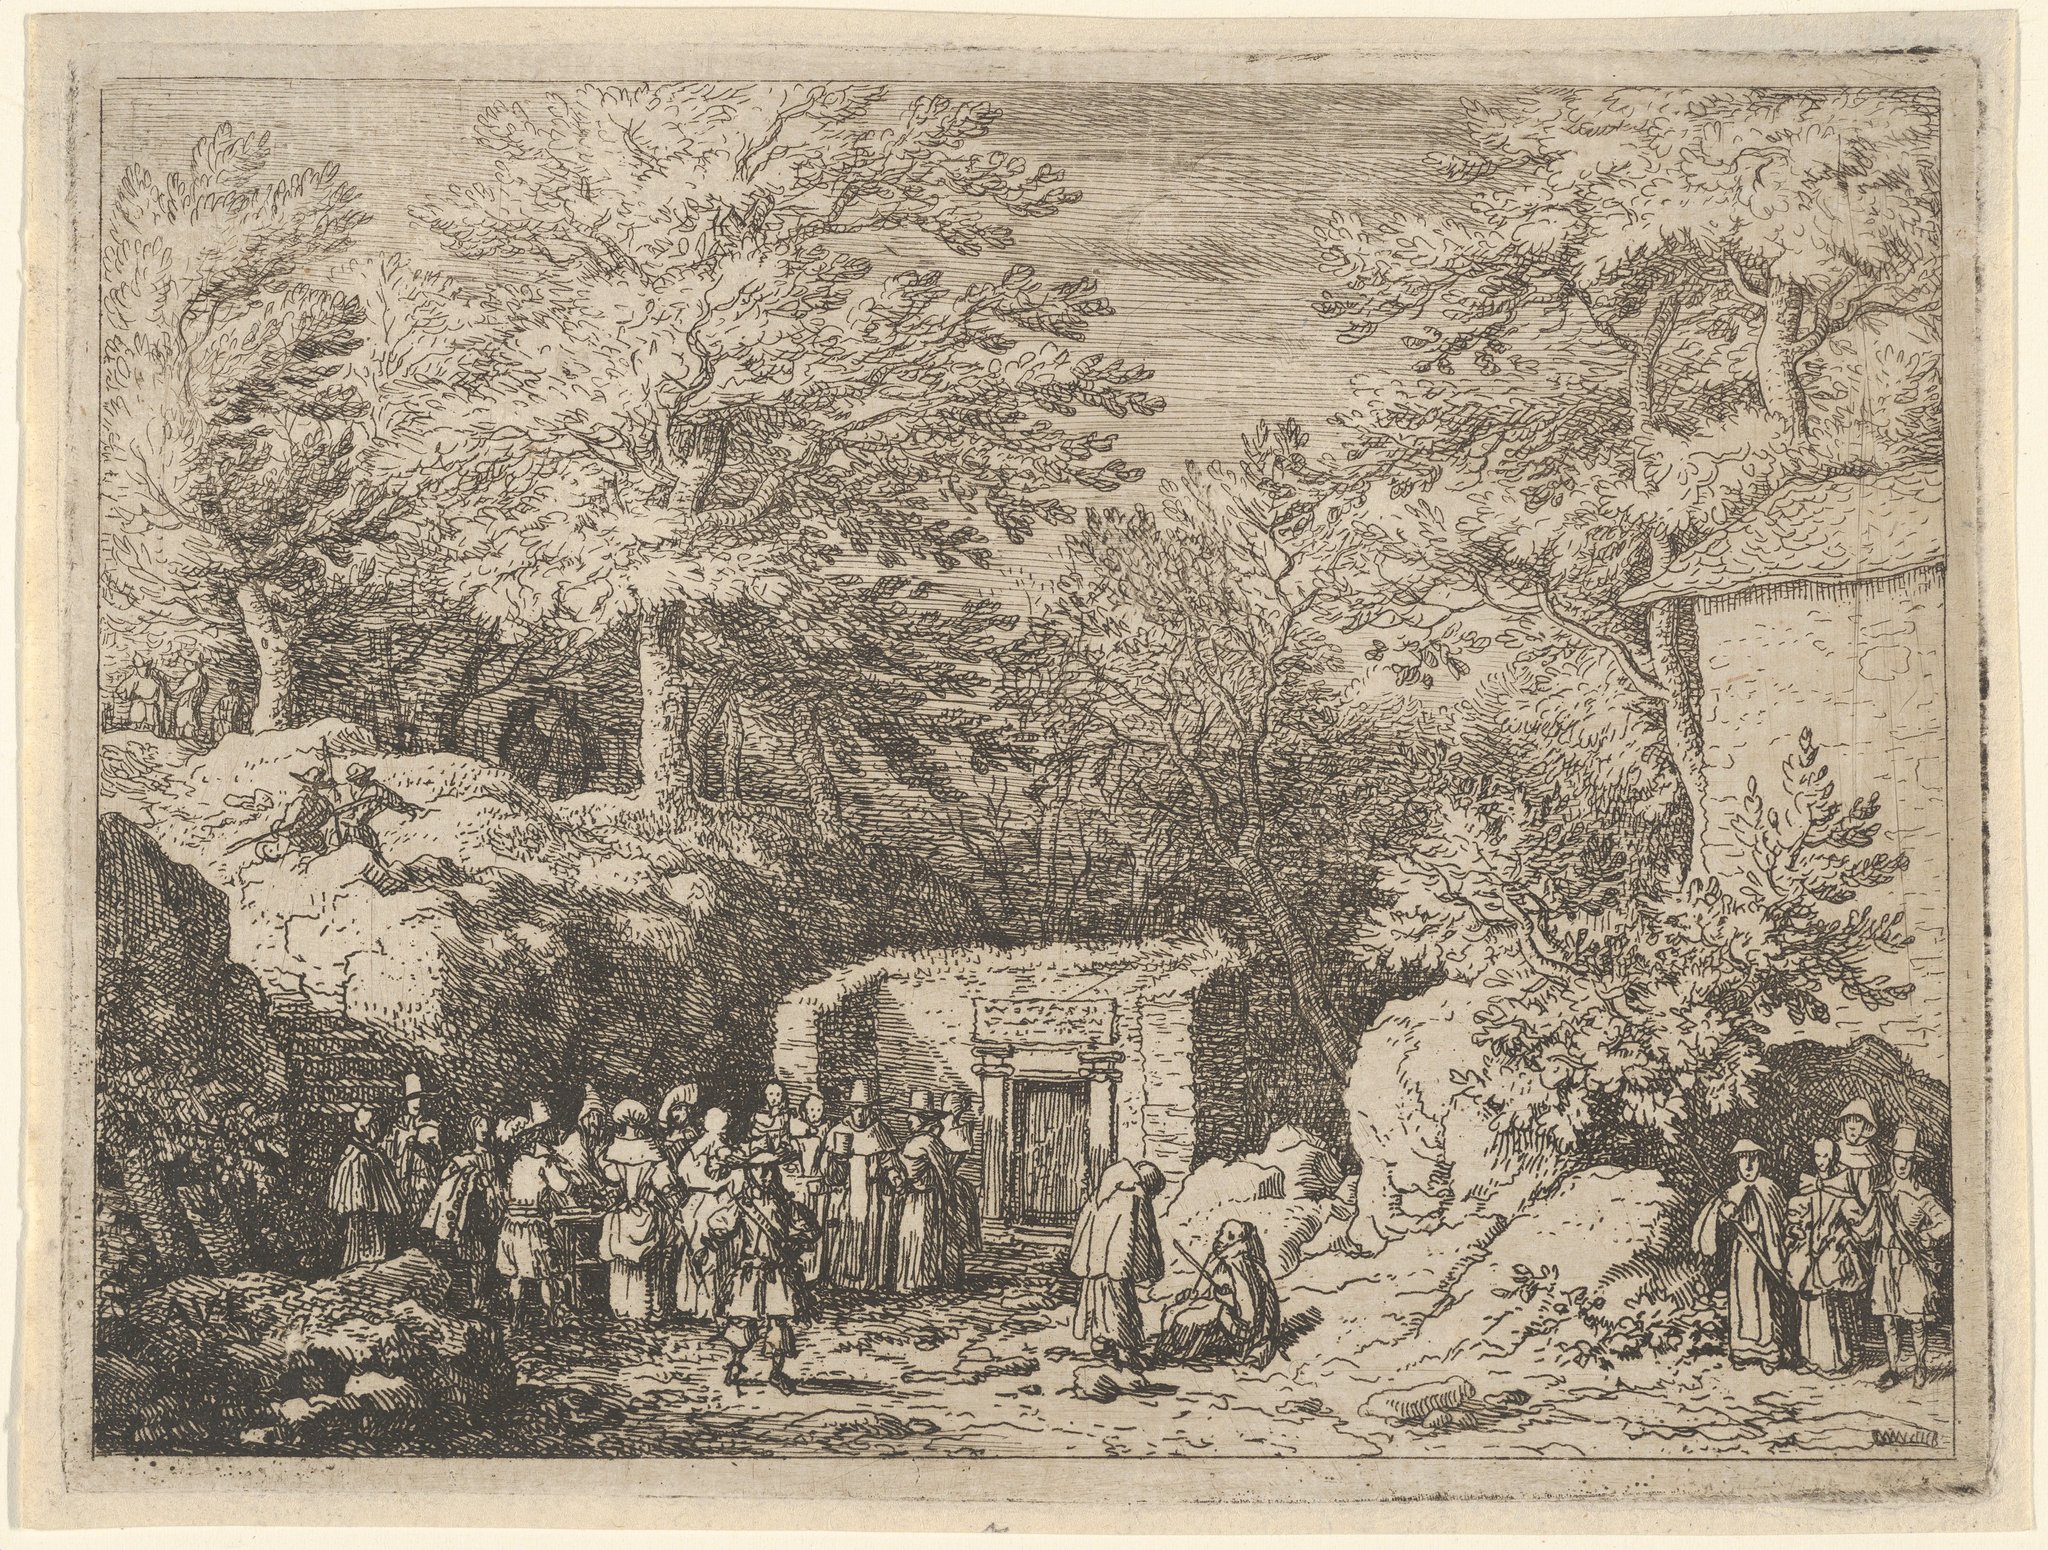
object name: print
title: The Fourth Spring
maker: allart van everdingen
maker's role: artist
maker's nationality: dutch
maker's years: 1621-1675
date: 1621-1675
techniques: etching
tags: human figures,trees,spring